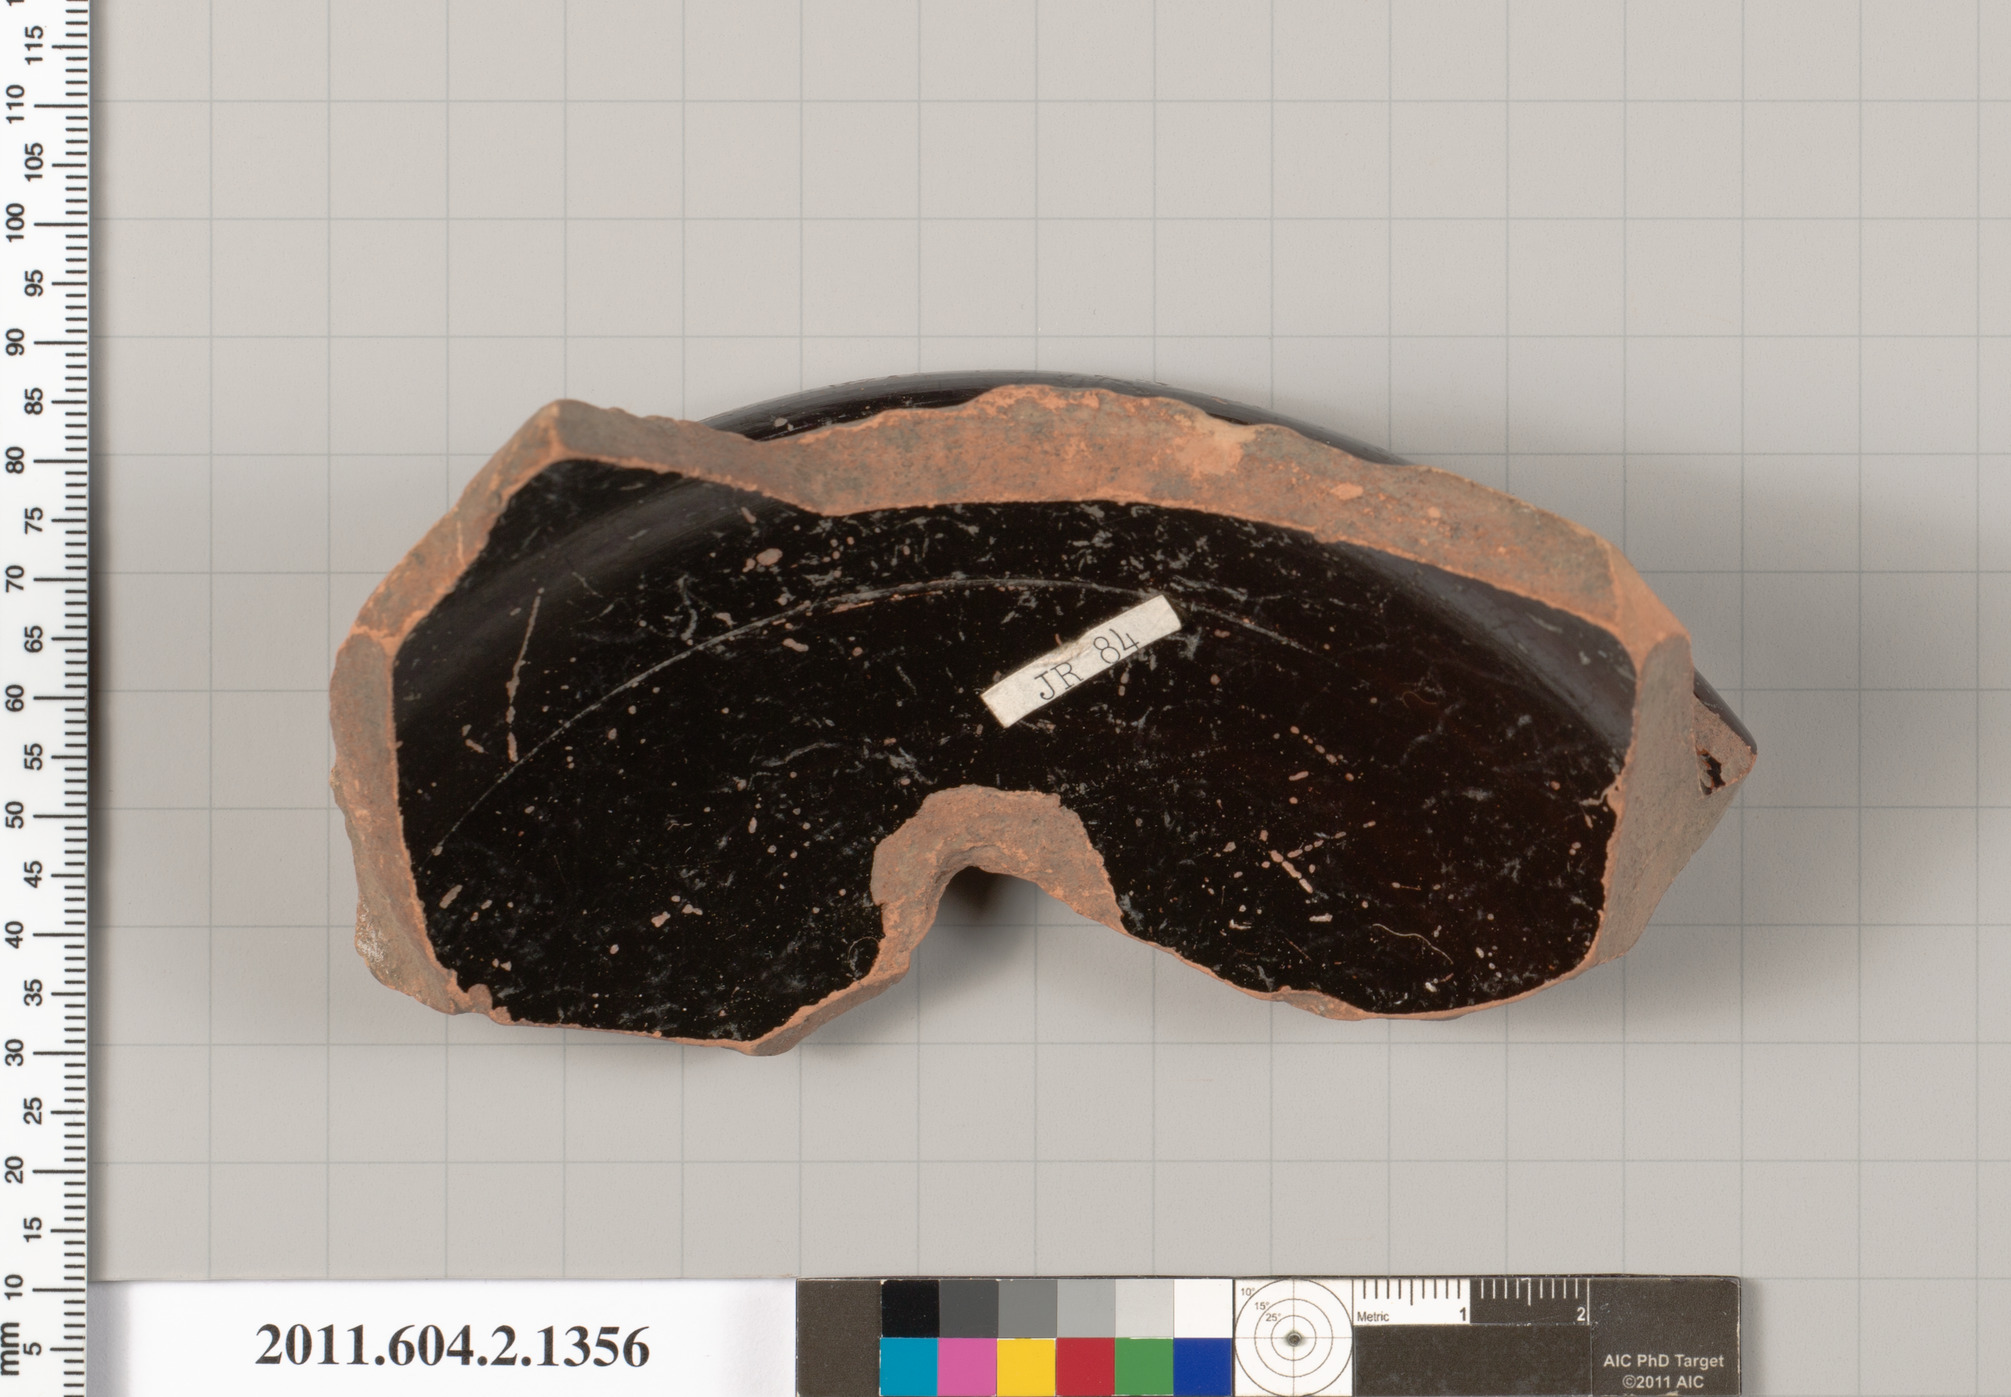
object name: skyphos fragment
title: Terracotta fragment of a skyphos (deep drinking cup)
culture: greek, attic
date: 475-451 BCE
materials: terracotta